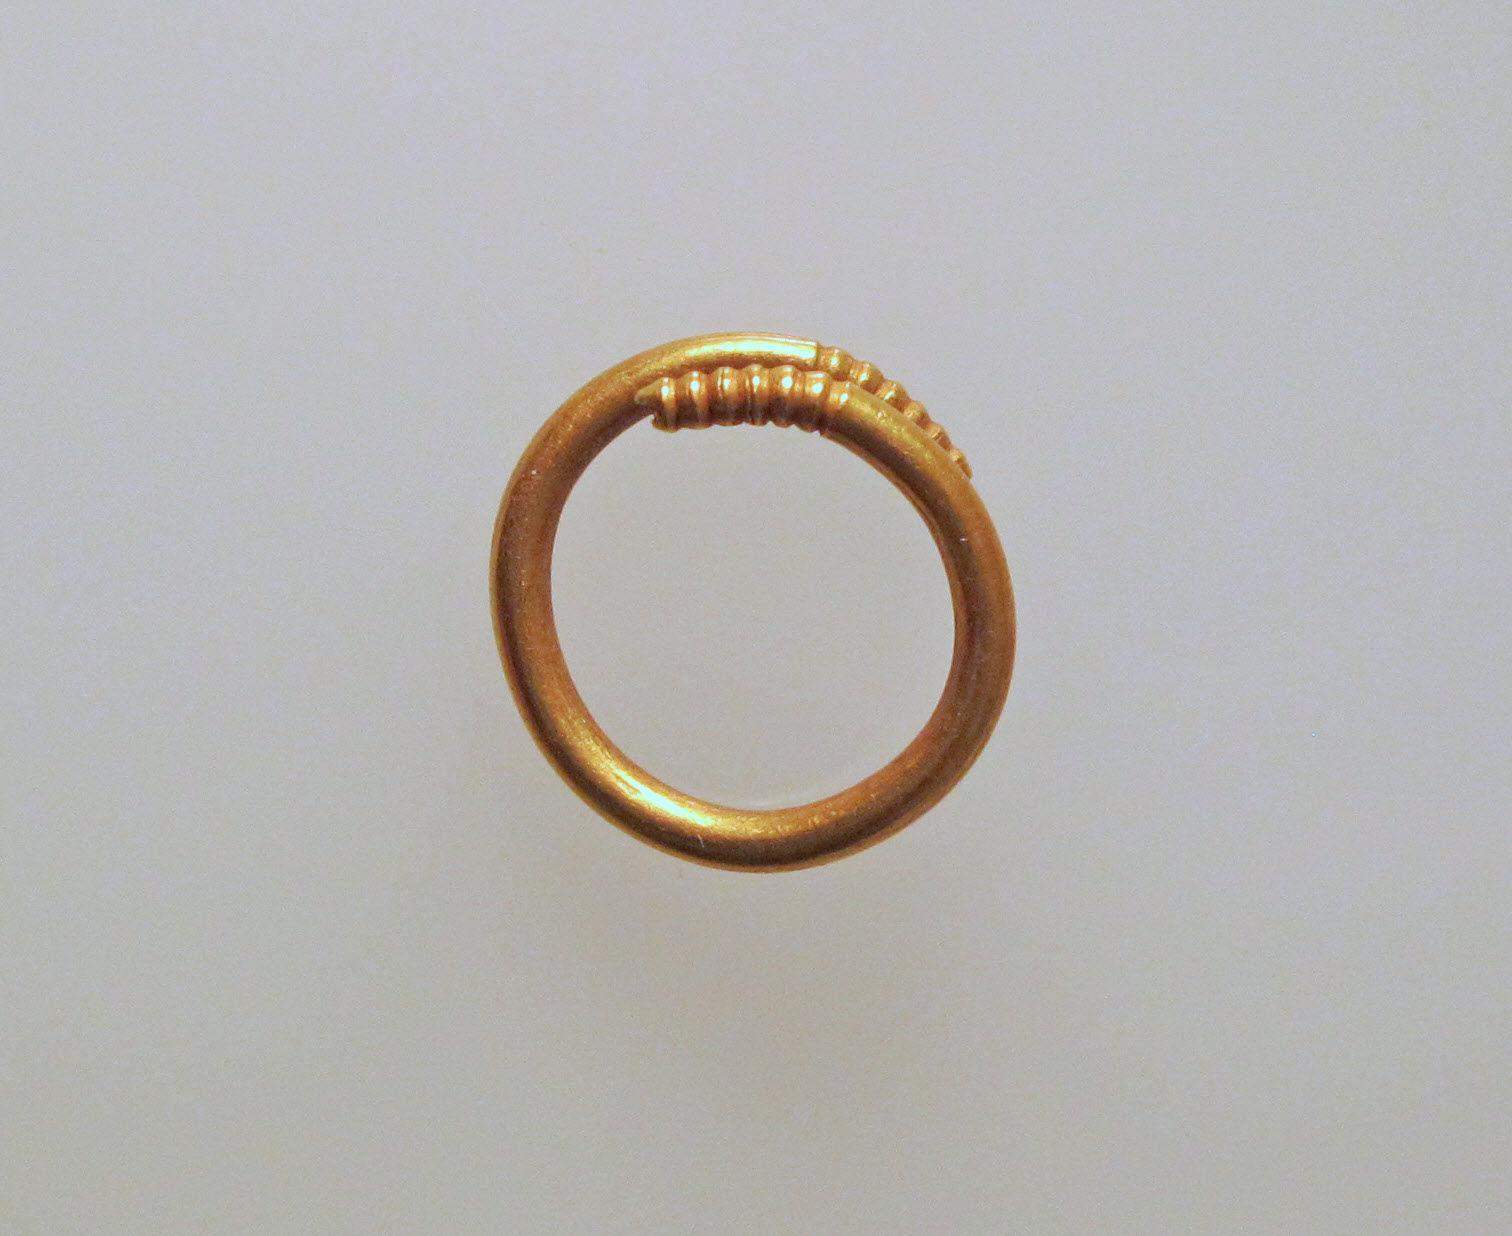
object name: spiral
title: Spirals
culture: cypriot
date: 3900 BCE-100 CE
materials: gold